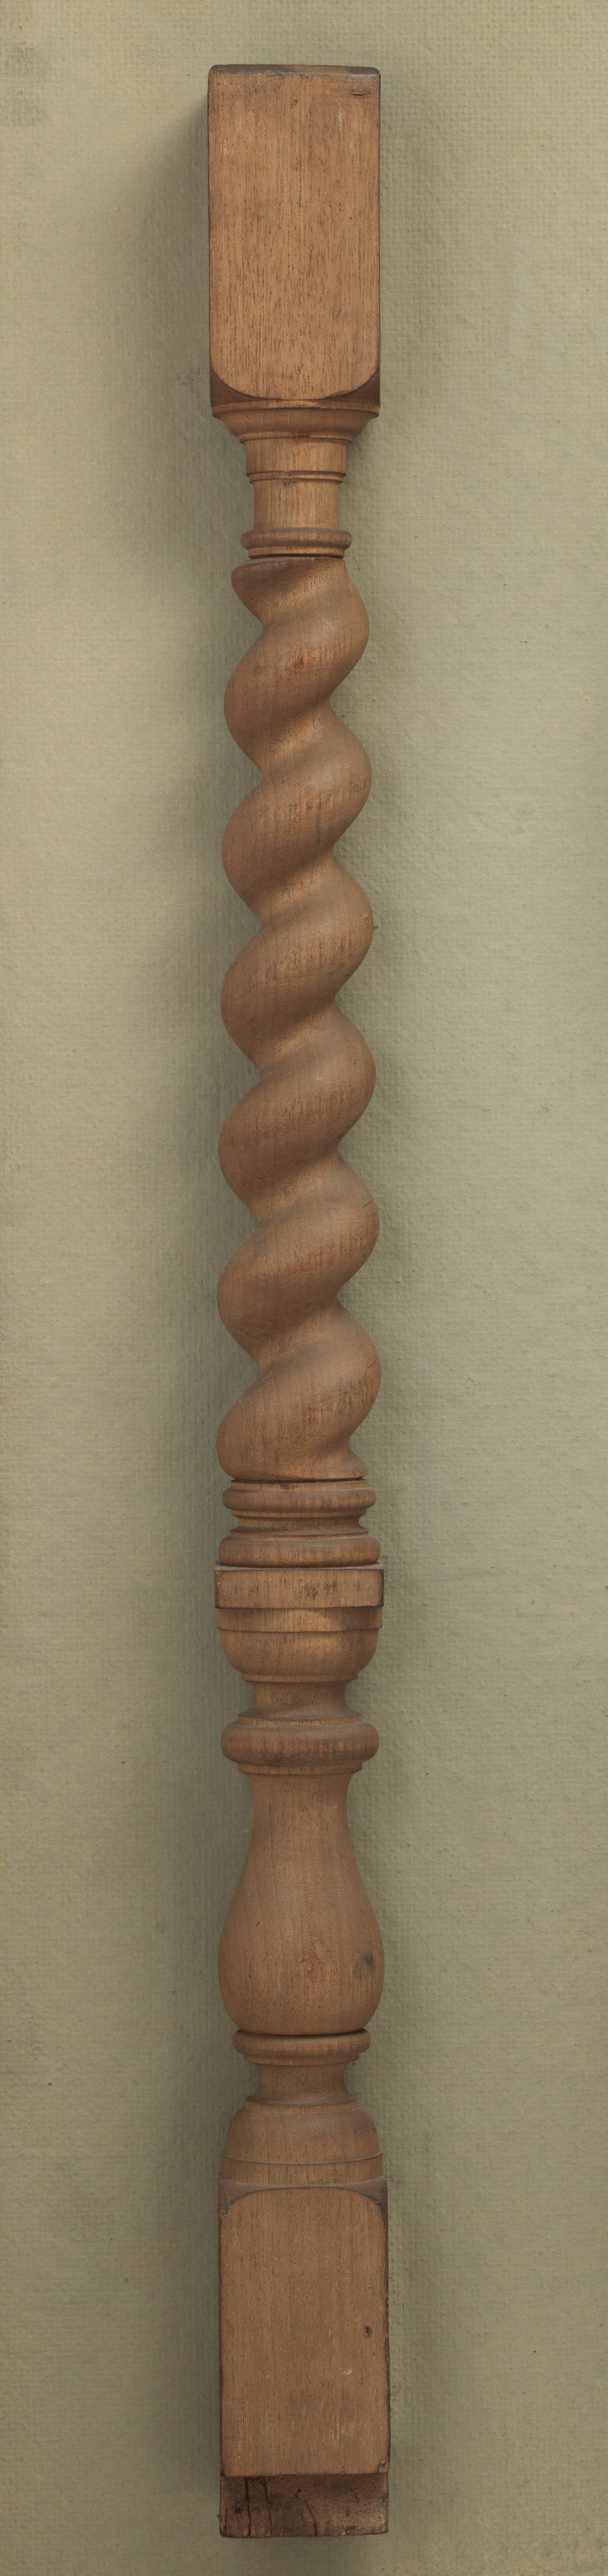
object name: baluster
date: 1701-1750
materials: wood